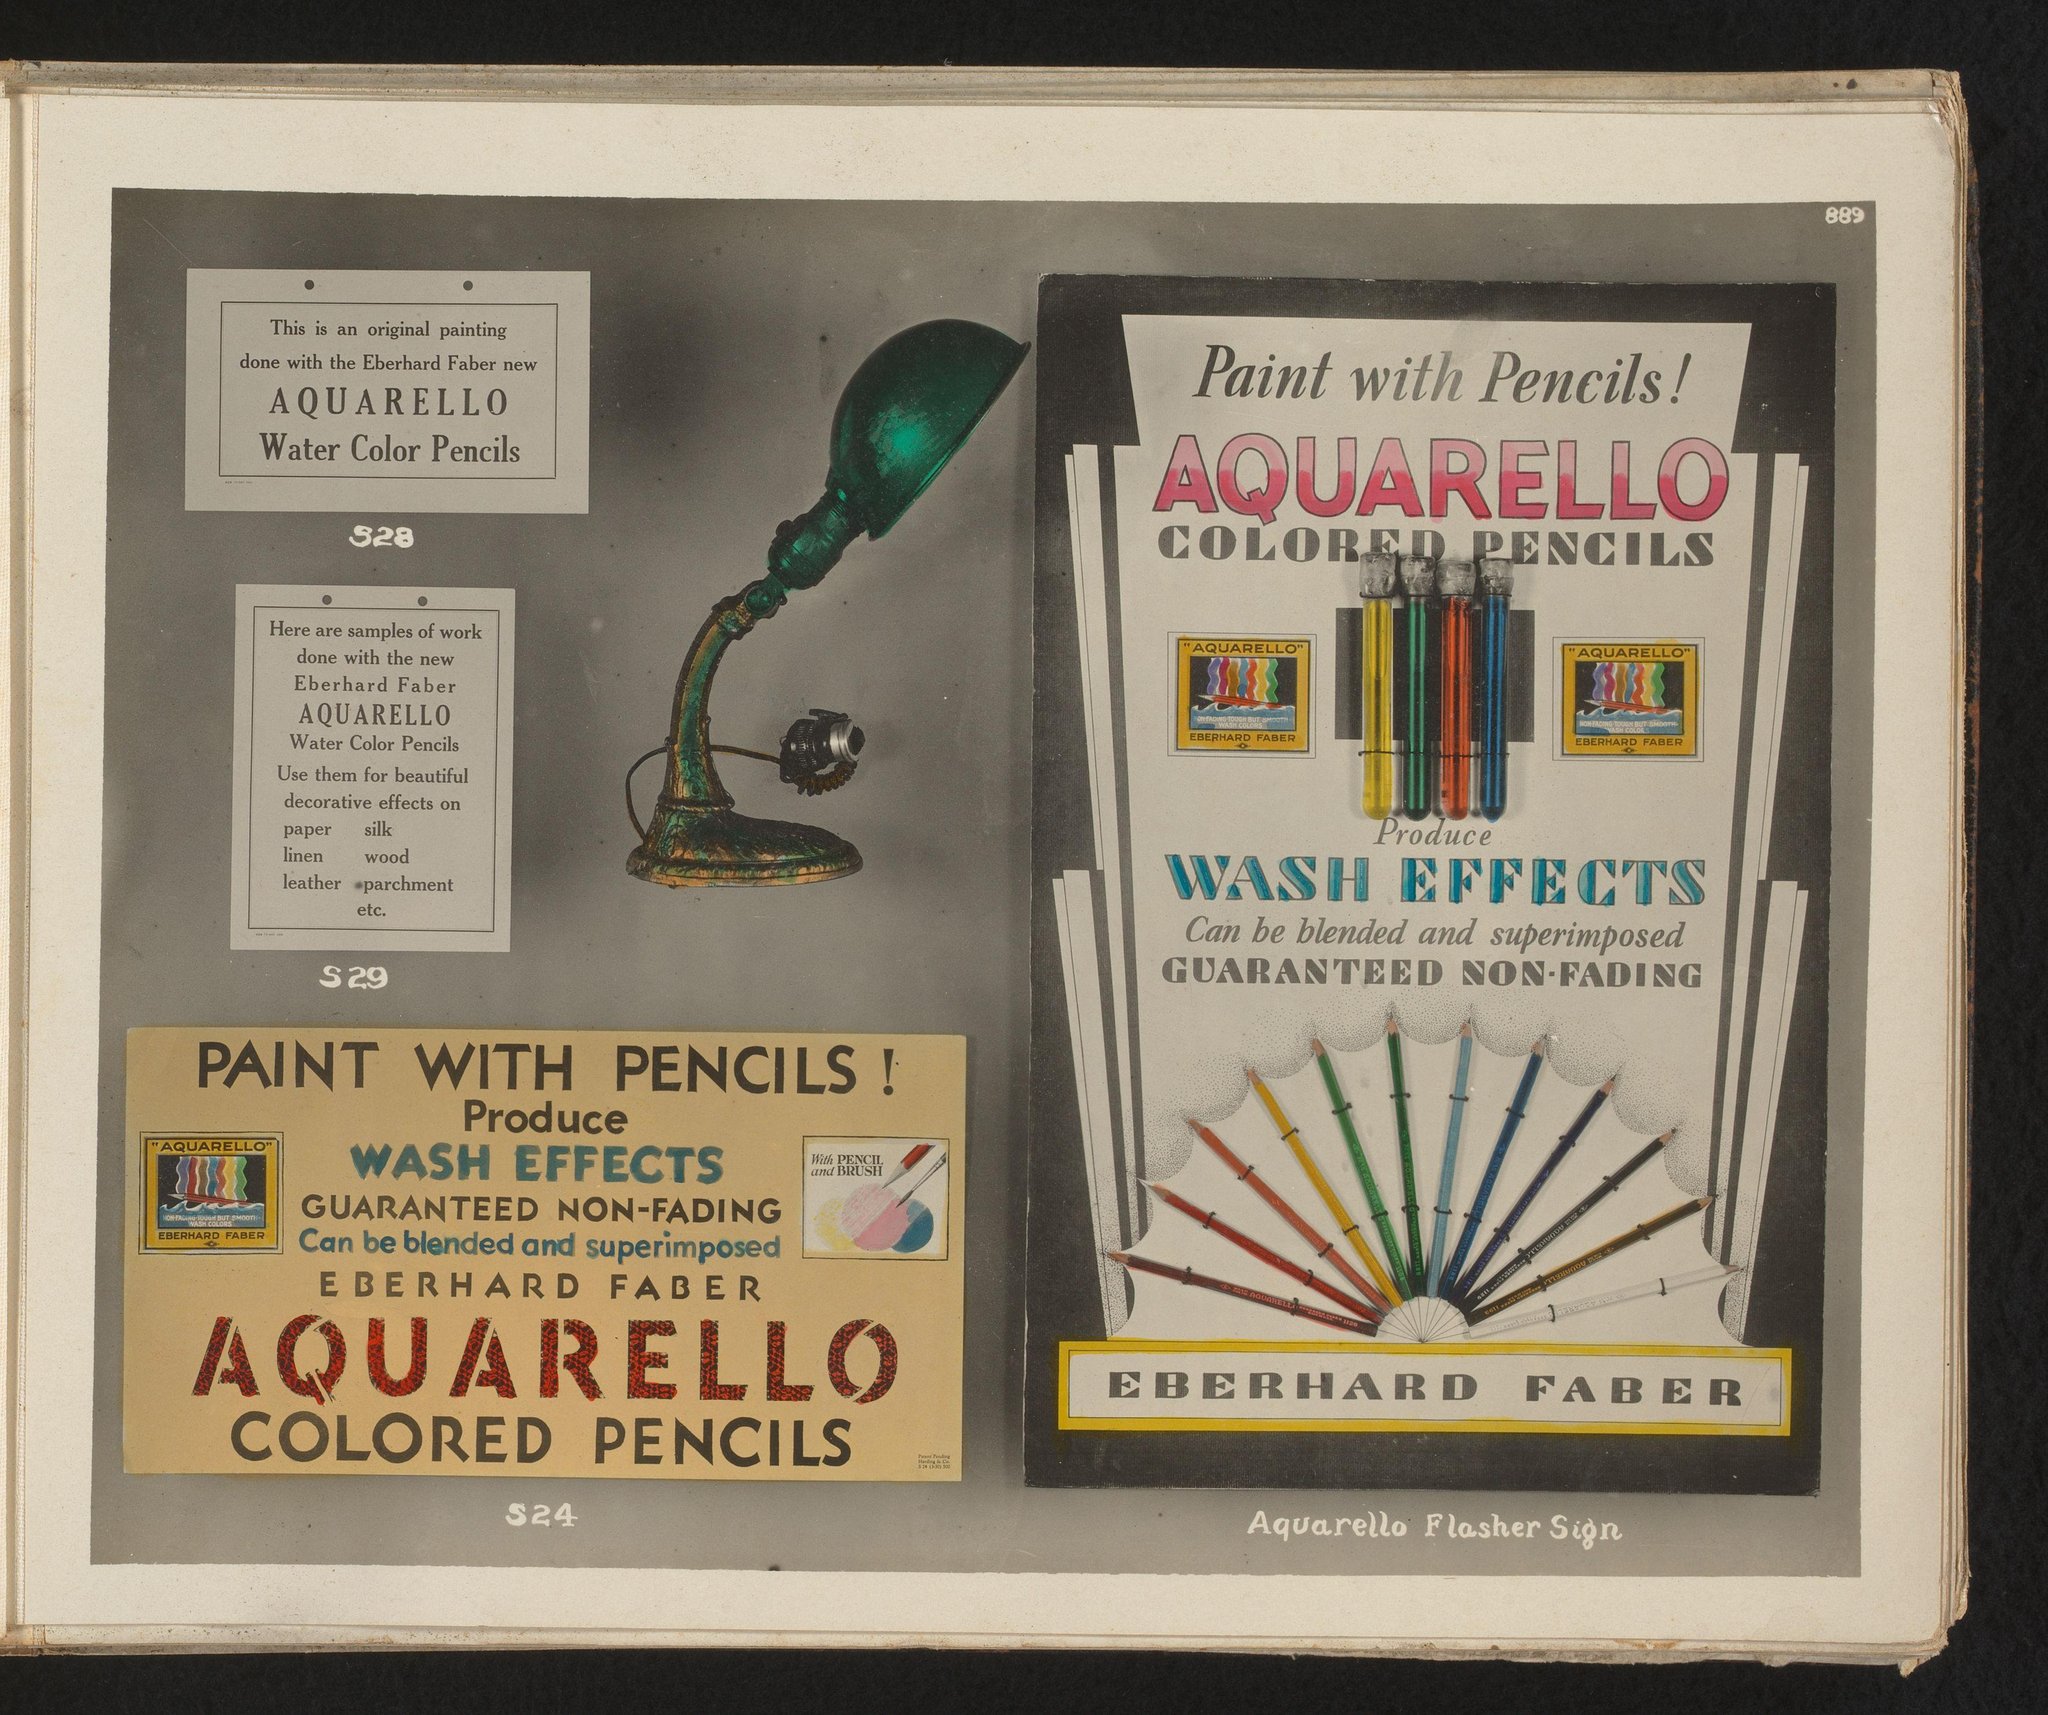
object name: album leaf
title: Reclame voor aquarelpotloden van Eberhard Faber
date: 1915-1935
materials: paper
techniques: gelatin silver print, hand coloring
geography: springfield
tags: pencil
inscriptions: stamp: ‘Paramount/ Commercial Studios/ 145 Chestnut St./ Springfield - Mass.’, number: ‘889’